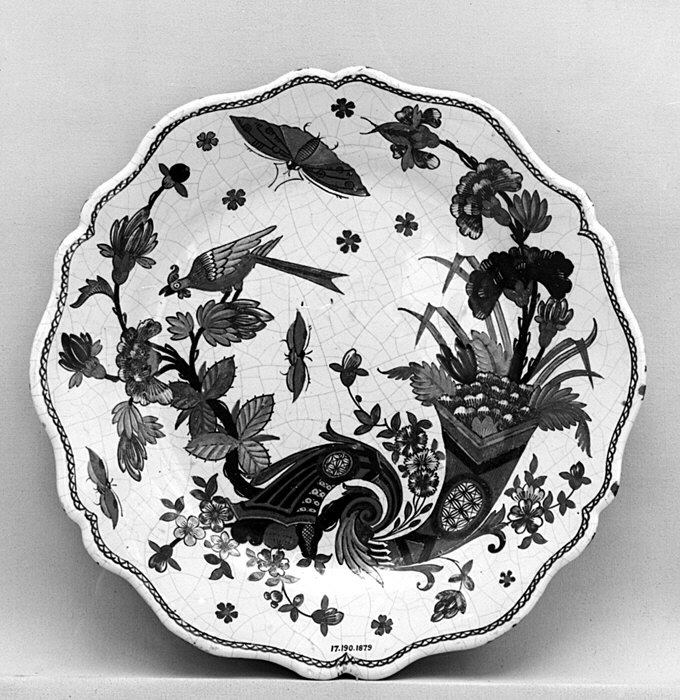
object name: plate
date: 1750-1760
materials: faience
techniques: glazing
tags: birds,insects,flowers